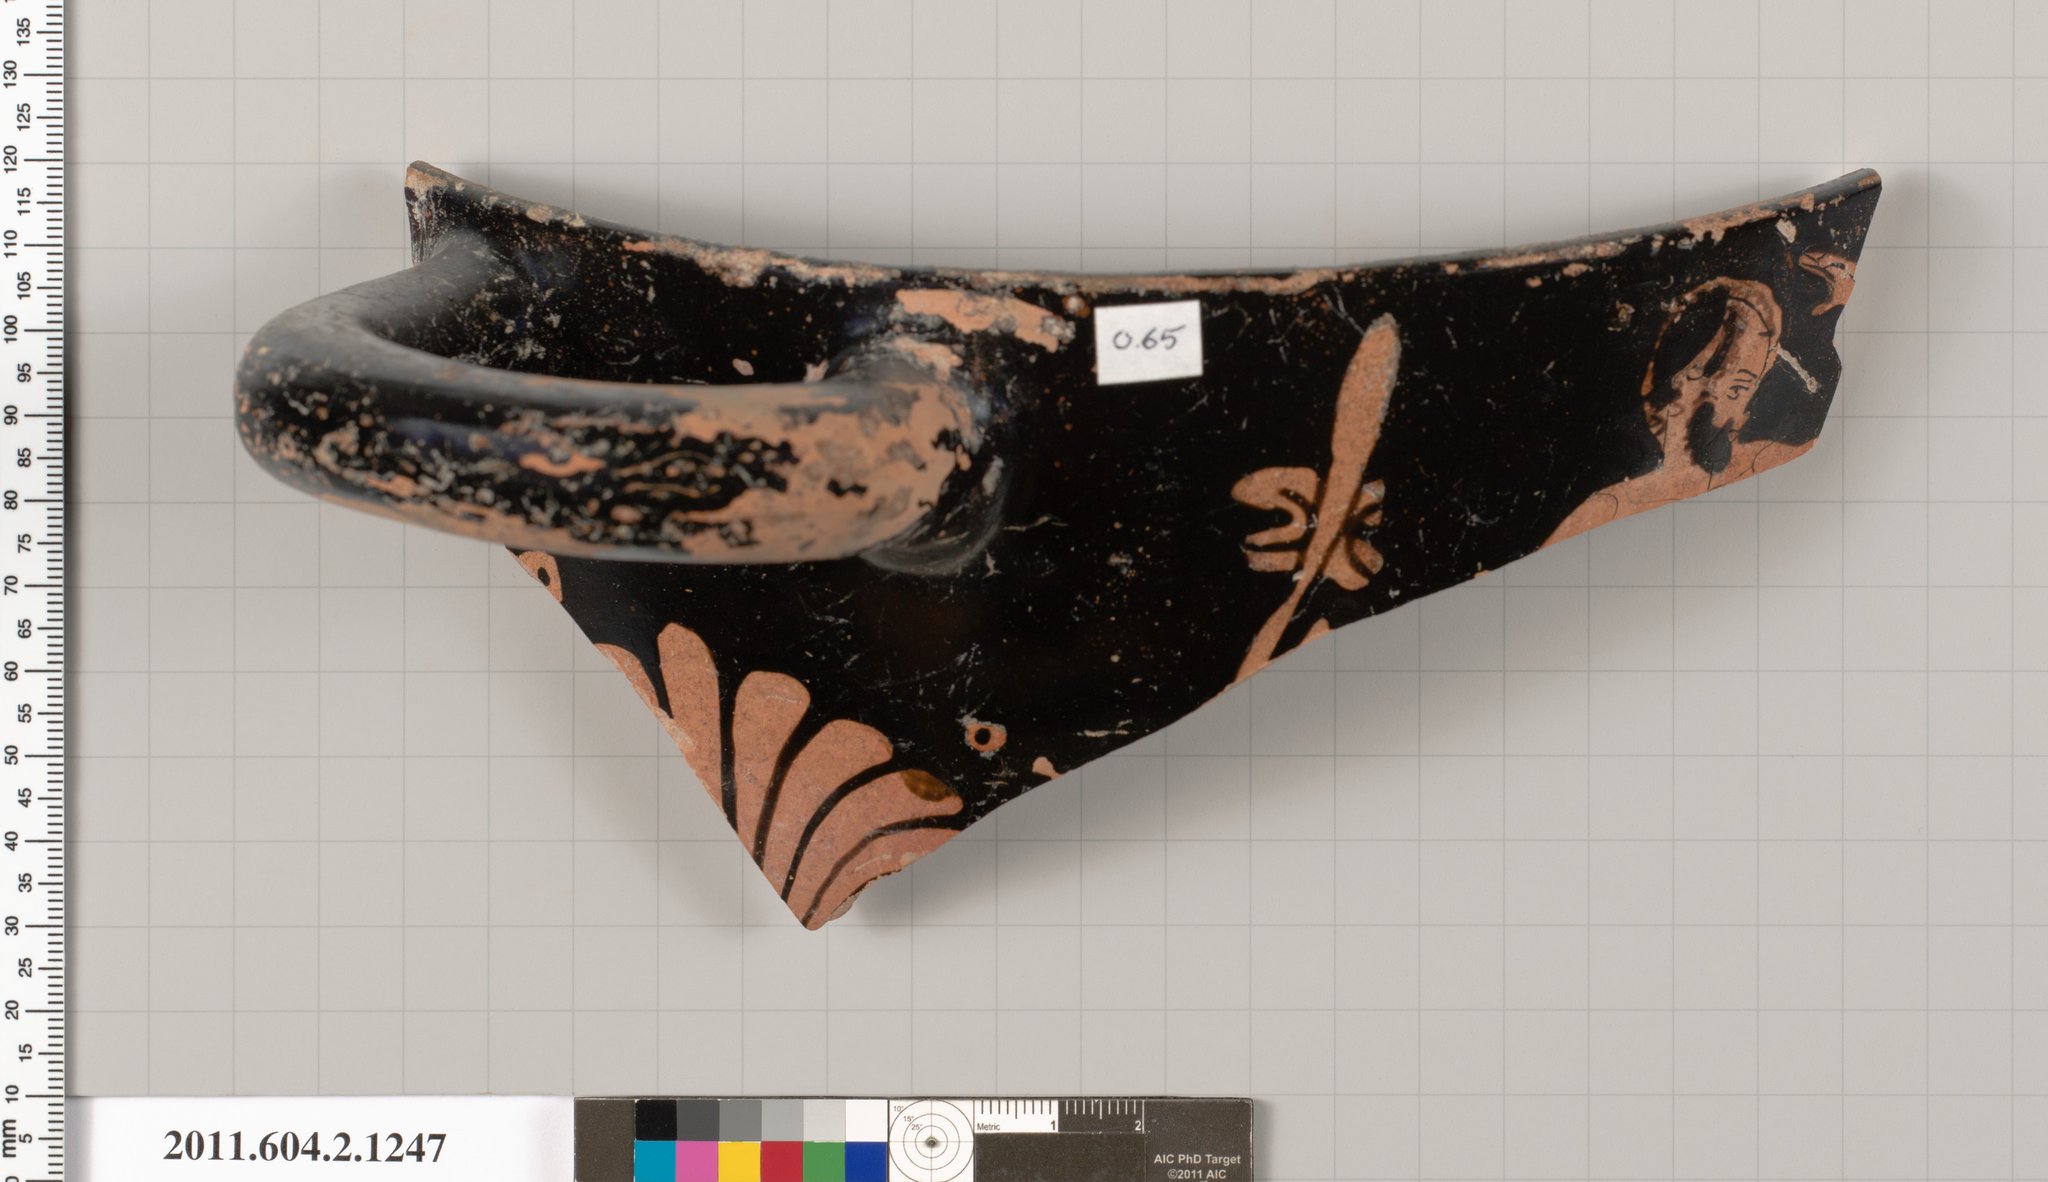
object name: skyphos fragment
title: Terracotta fragment of a skyphos (deep drinking cup)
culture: greek, attic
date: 440-430 BCE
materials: terracotta